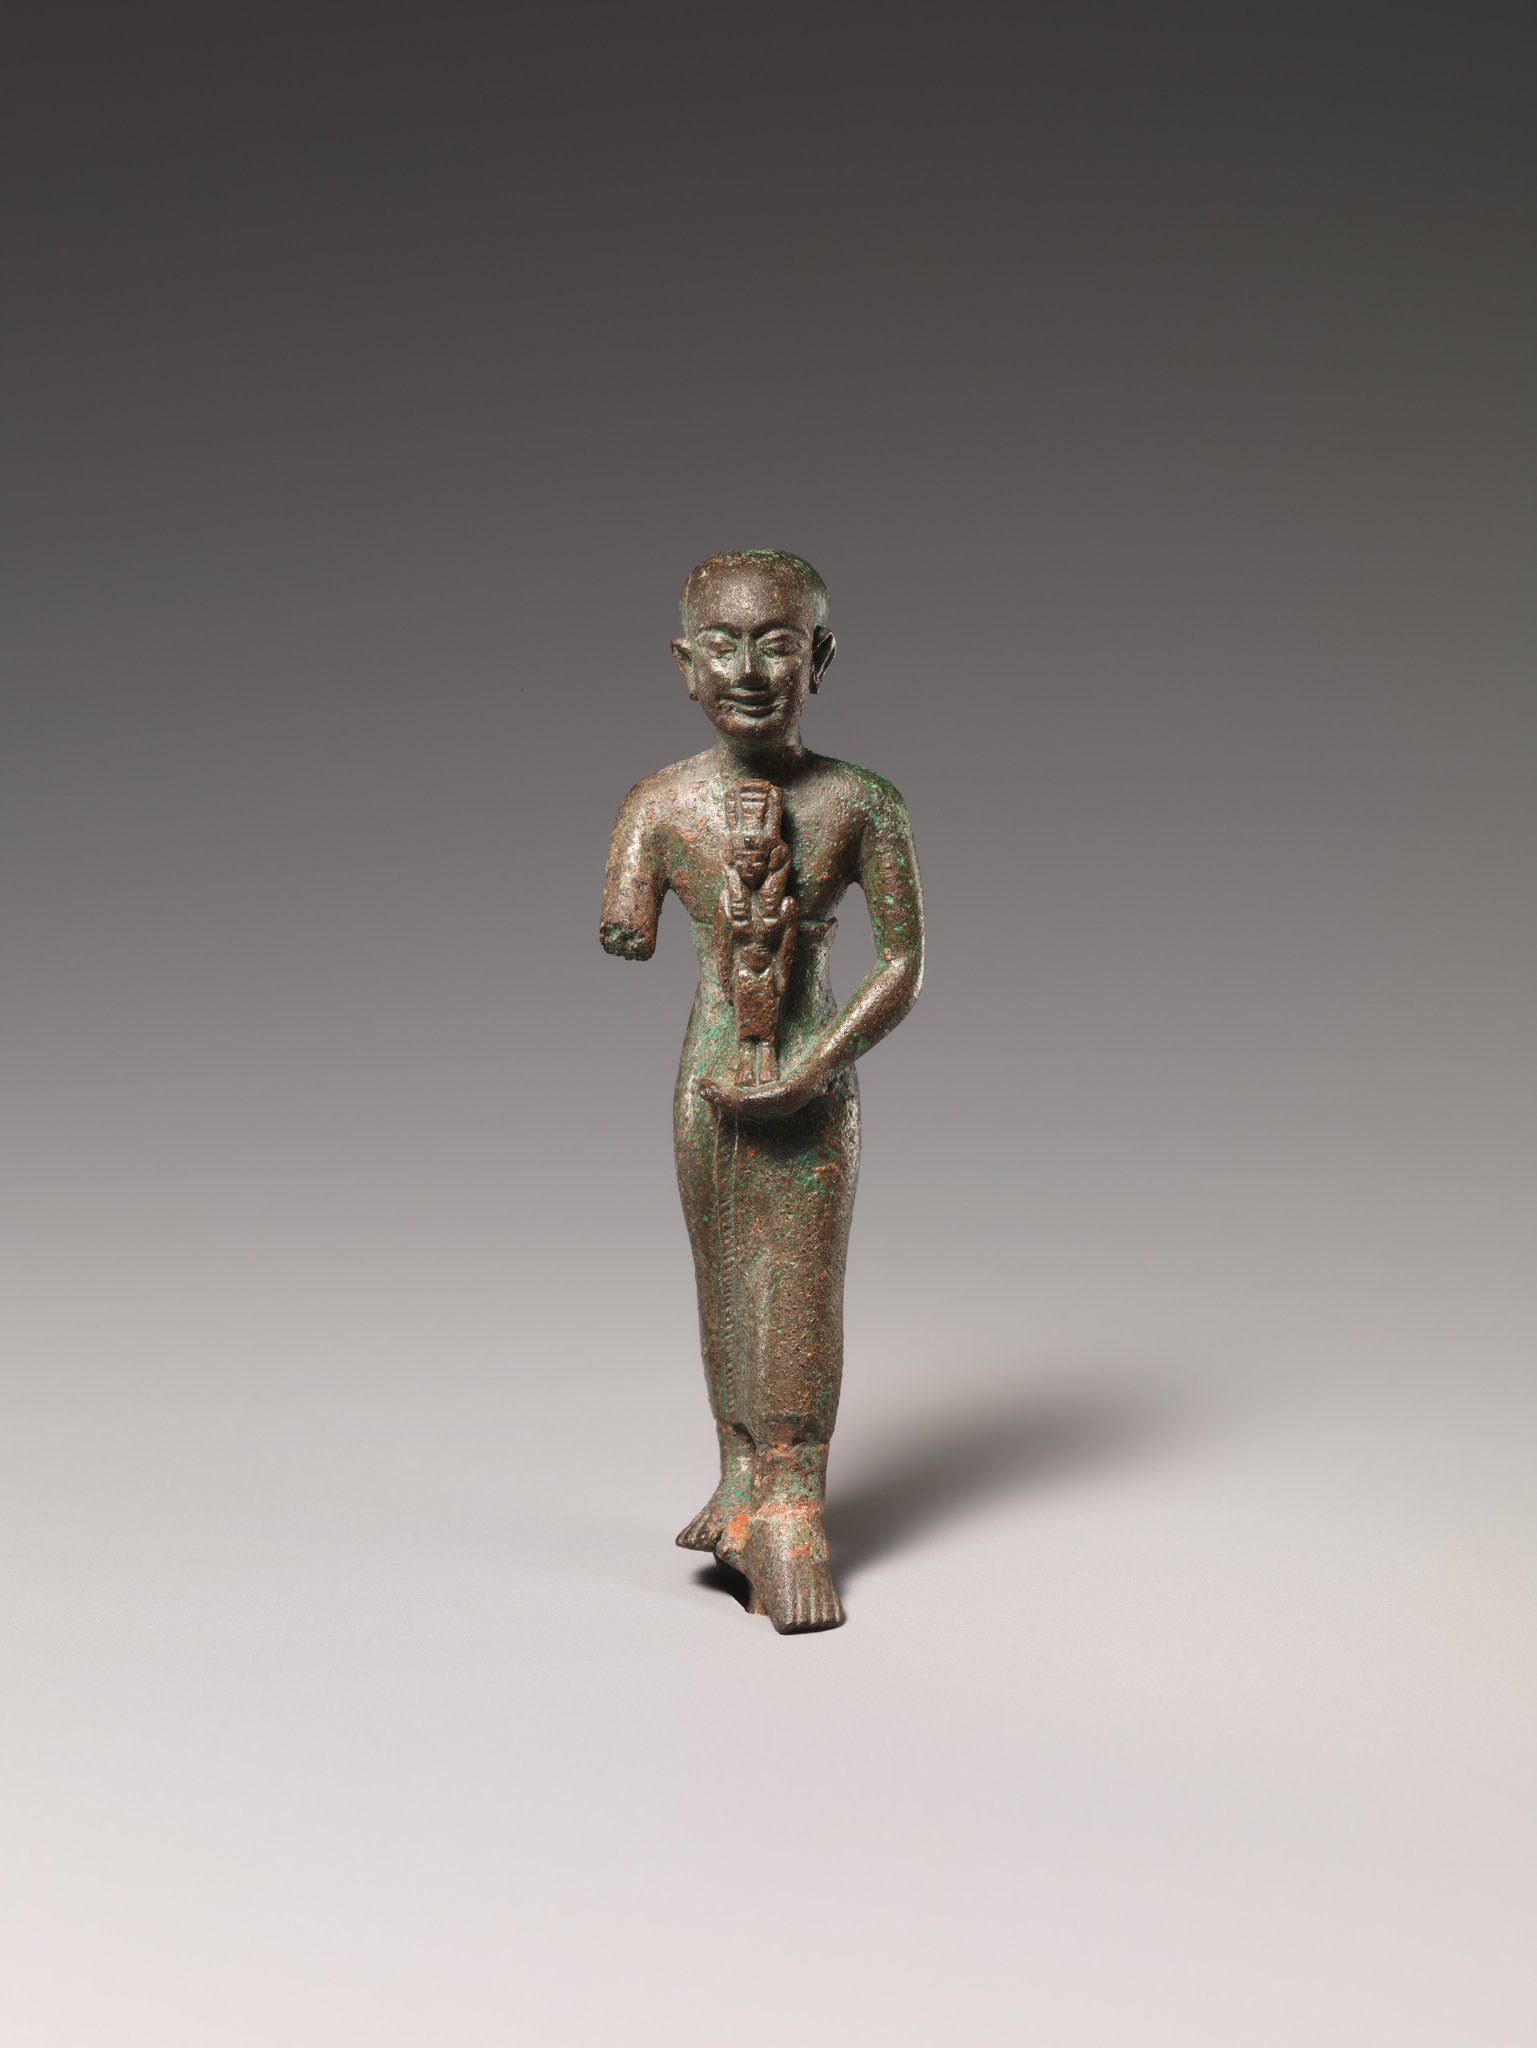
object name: standing man, nebethetepet or nehemetaui figurine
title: Standing man holding statuette of Nebethetepet or Nehemetaway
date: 600-200 BCE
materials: metal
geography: egypt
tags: men,goddess